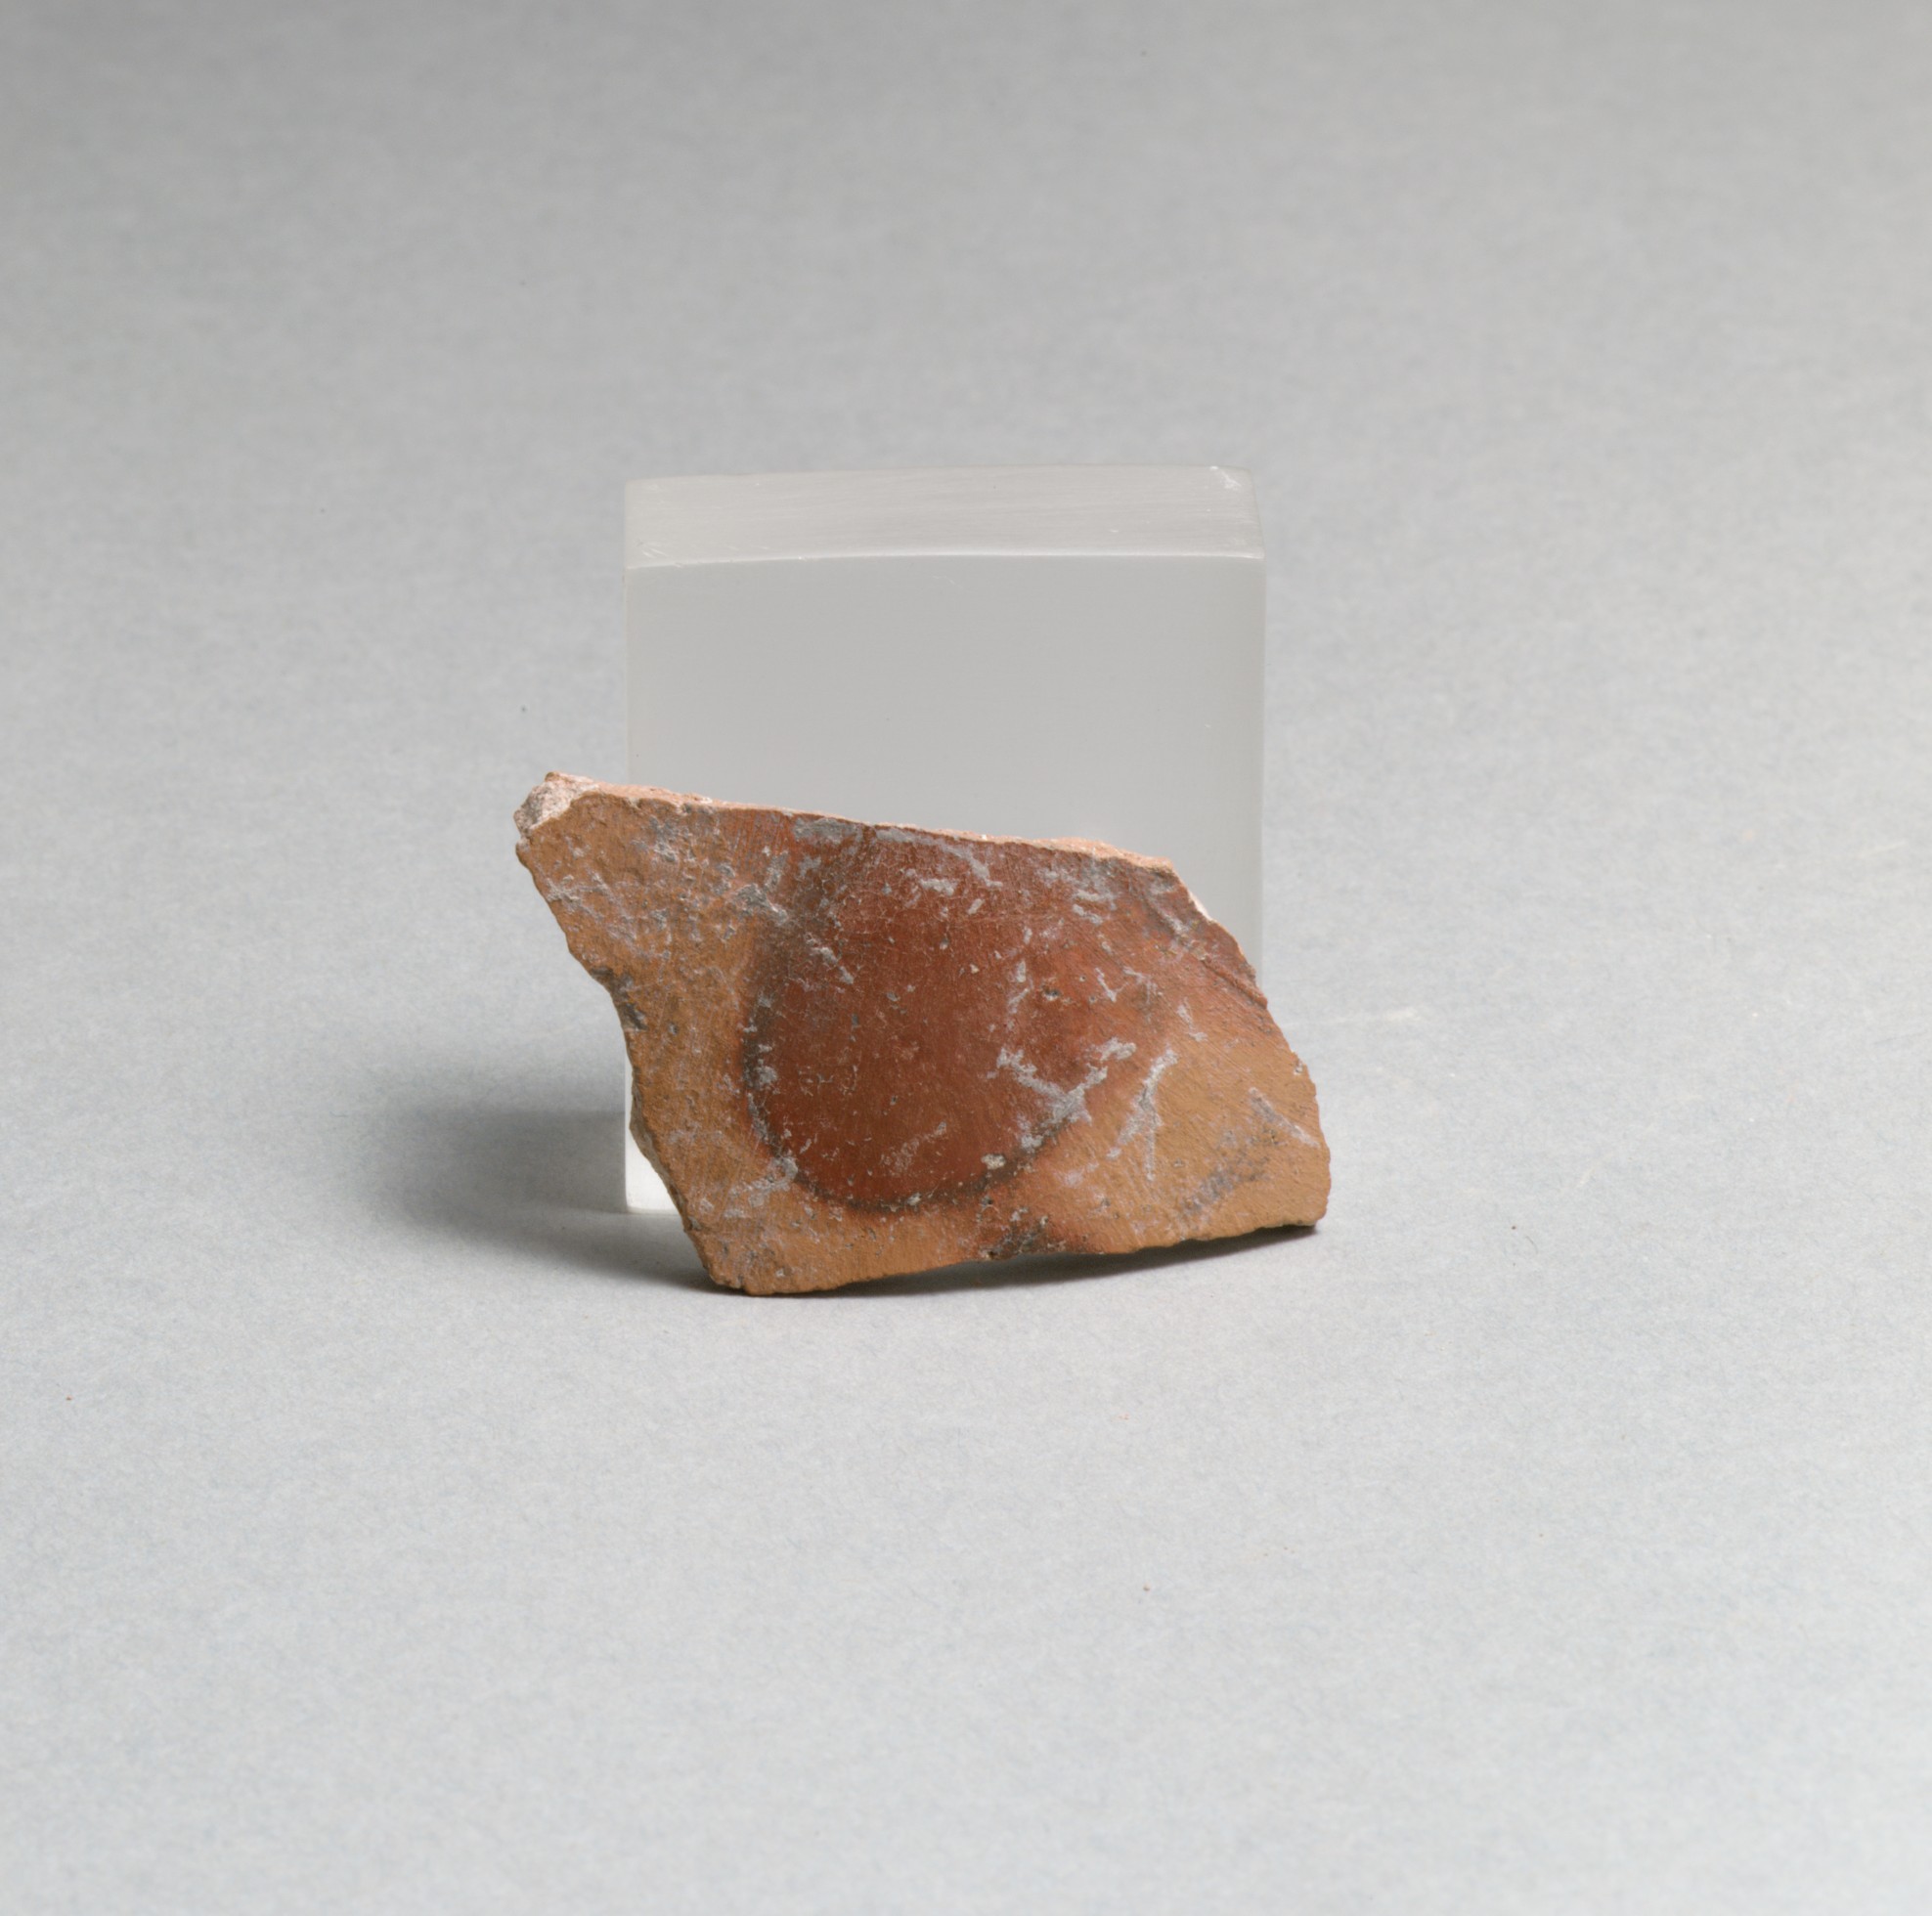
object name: vase fragment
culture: minoan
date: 2600-2000 BCE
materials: terracotta